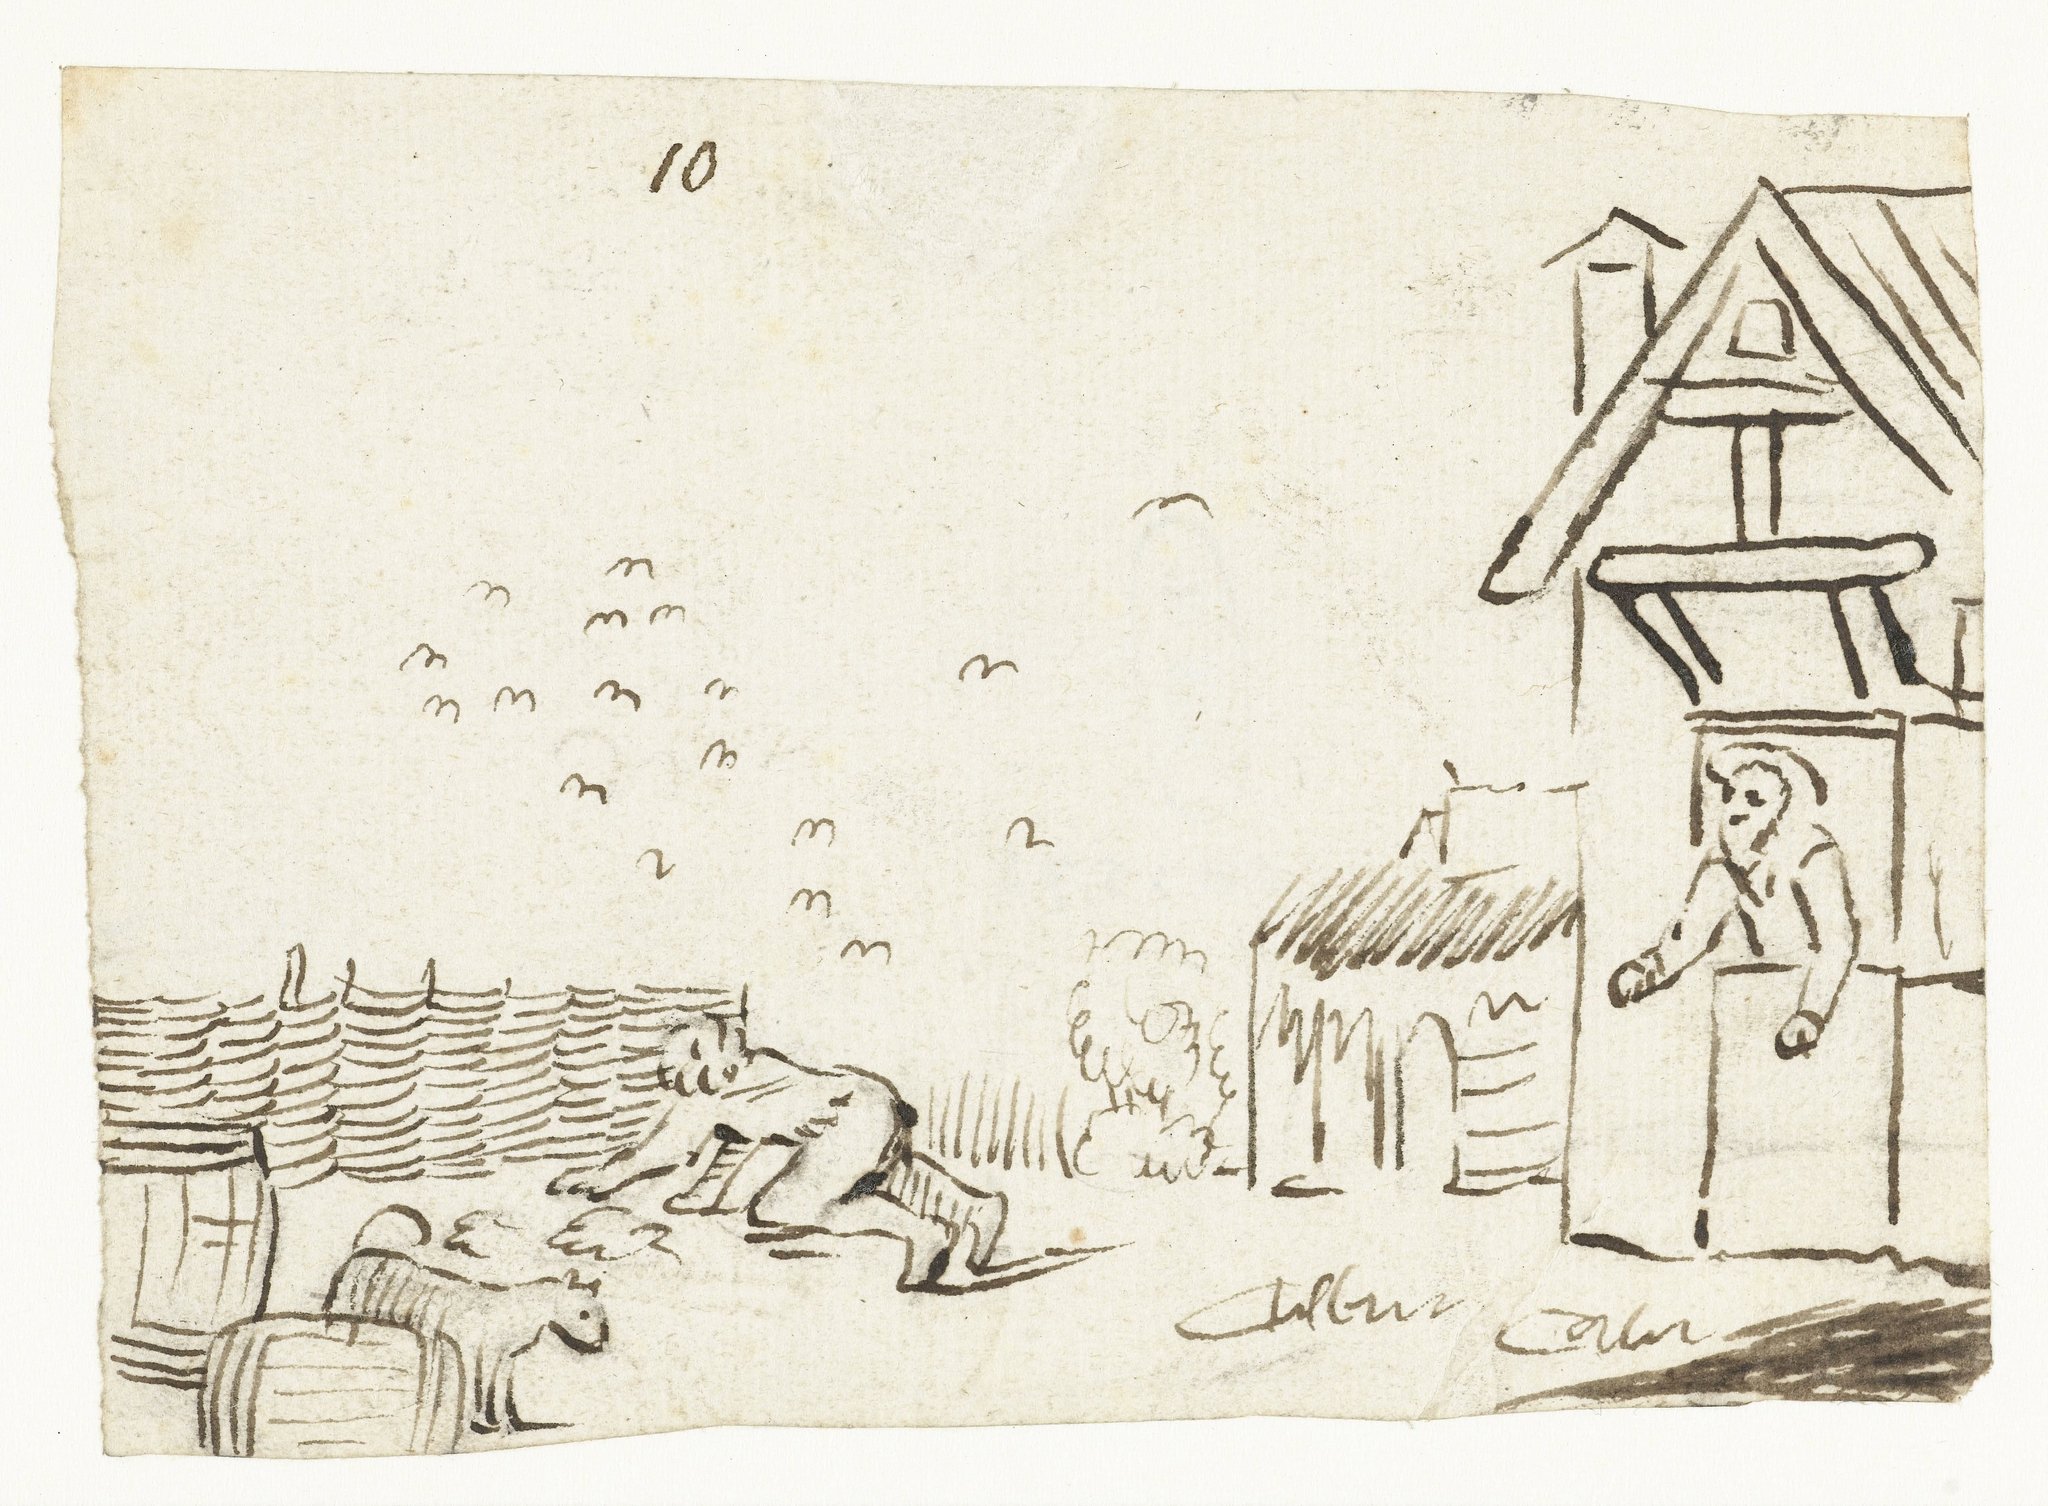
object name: drawing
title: Man kijkend naar een jongen met een vogelval (?).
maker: moses ter borch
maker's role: draughtsman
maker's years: 1645-1667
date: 1656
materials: ink, paper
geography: zwolle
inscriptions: annotation: ‘10’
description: Maakt deel uit van een groep tekeningen (cat.nr. M 8 t/m M 20) toegeschreven aan Moses ter Borch.